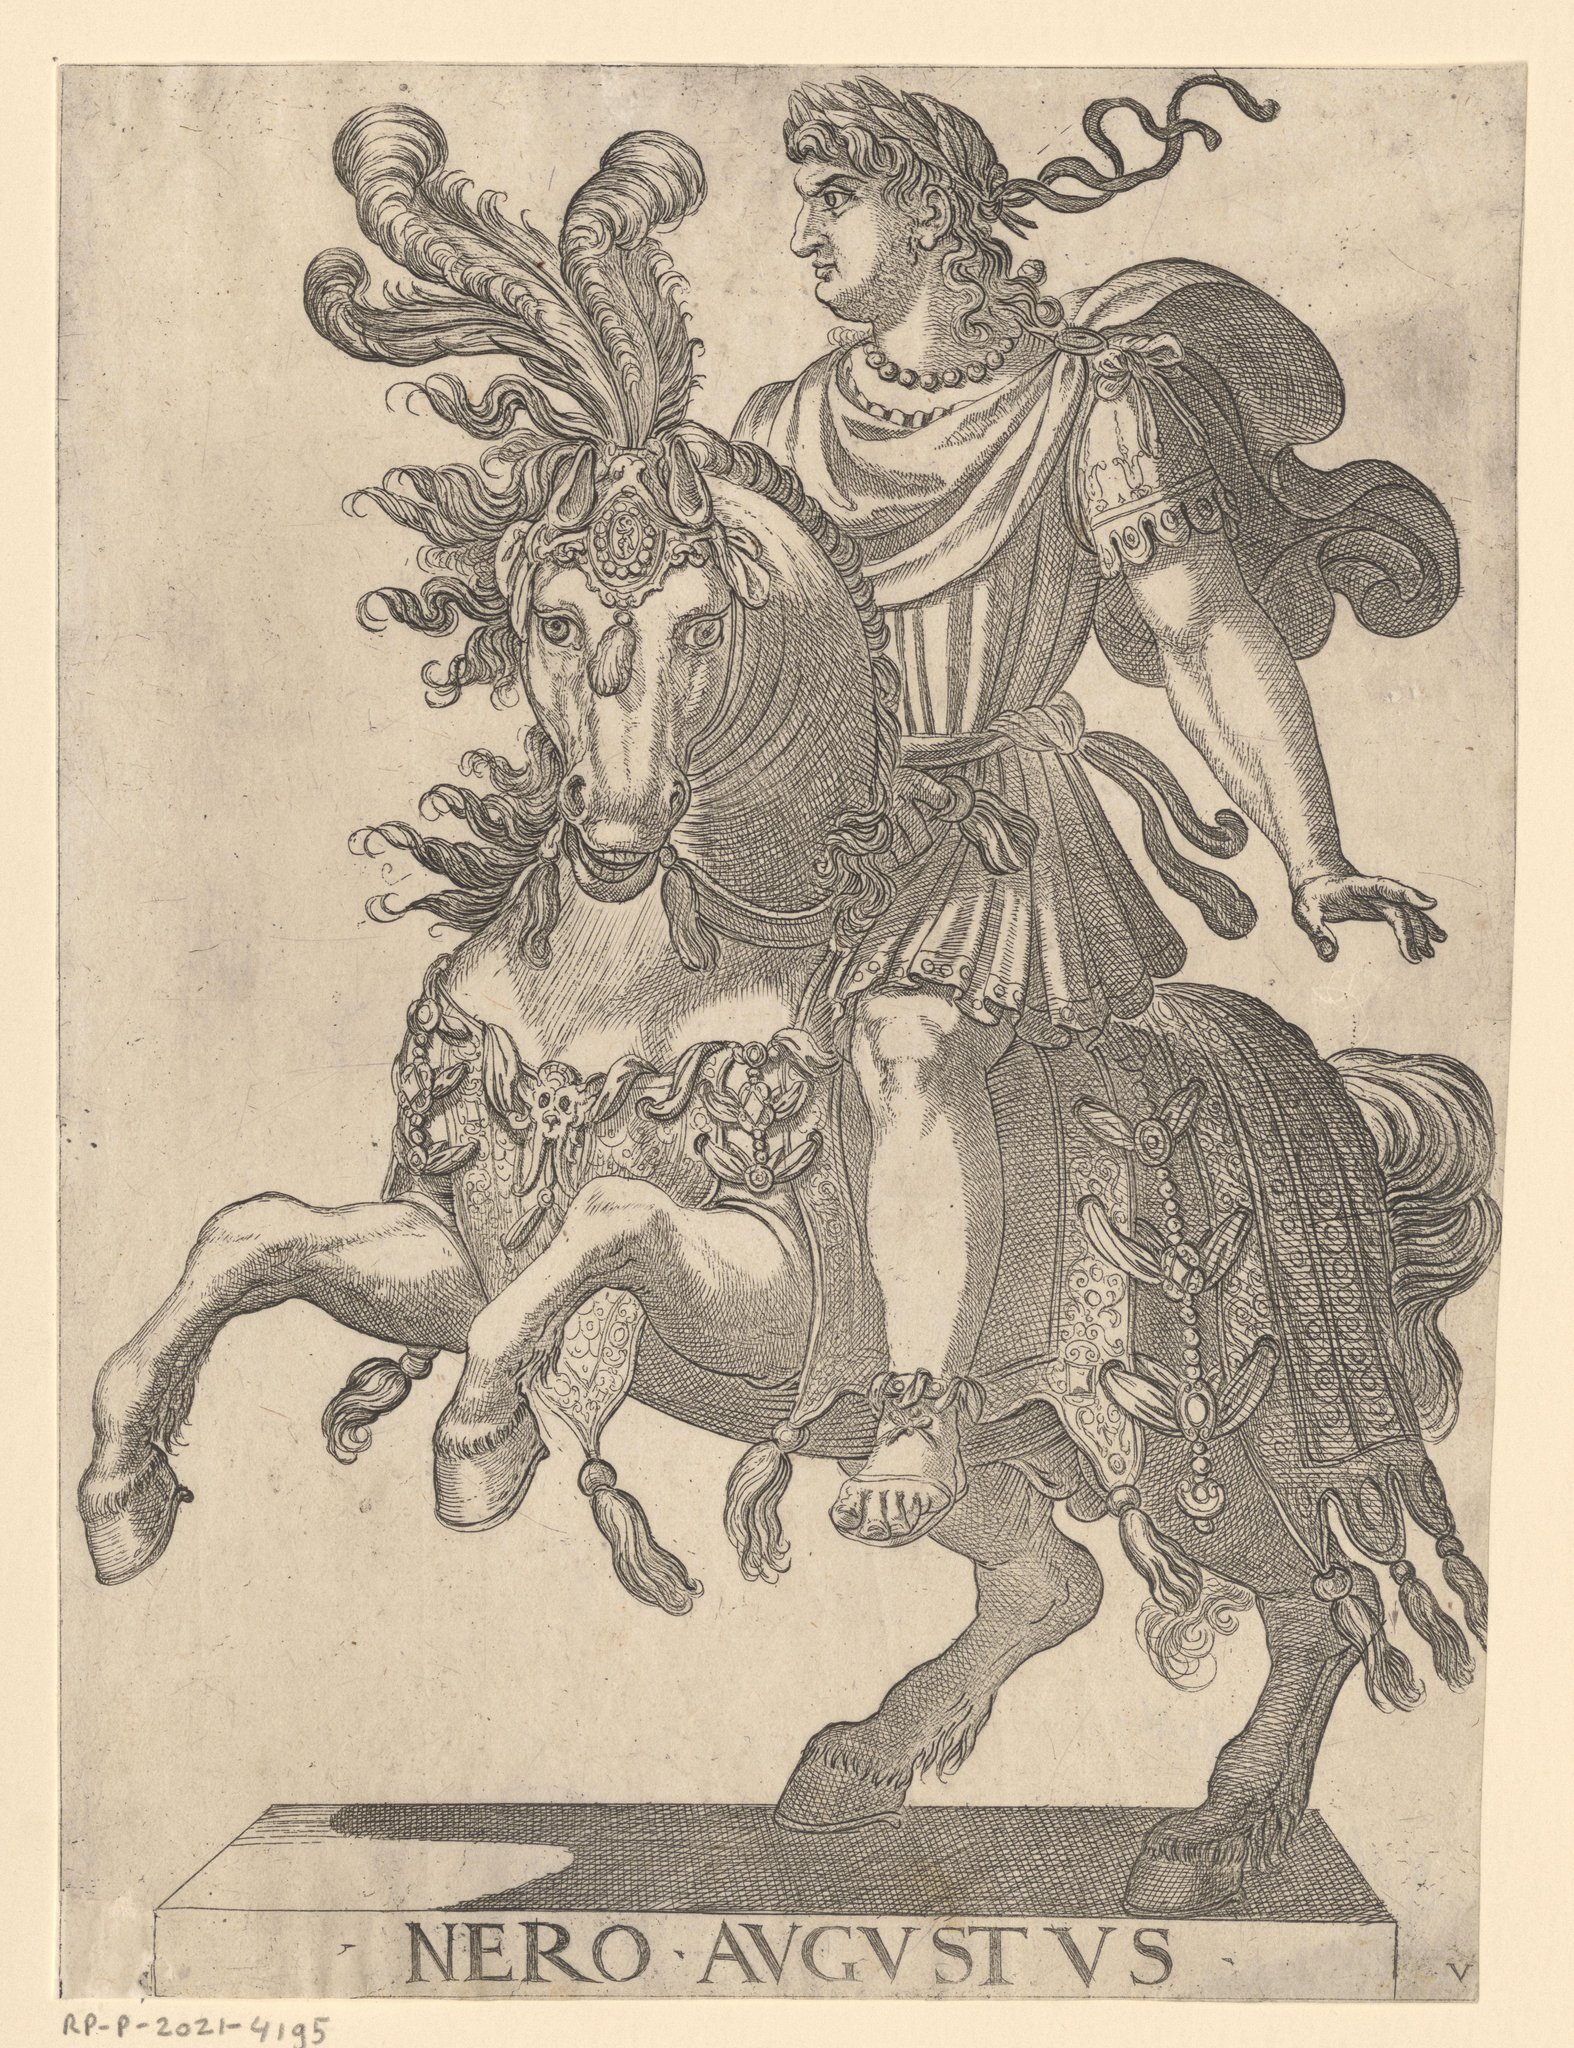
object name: print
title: Ruiterportret van Nero, keizer van het Romeinse Rijk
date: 1595-1596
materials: paper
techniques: etching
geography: rome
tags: (story of) nero, the roman emperor - portrait of person from classical history, historical persons, equestrian statue